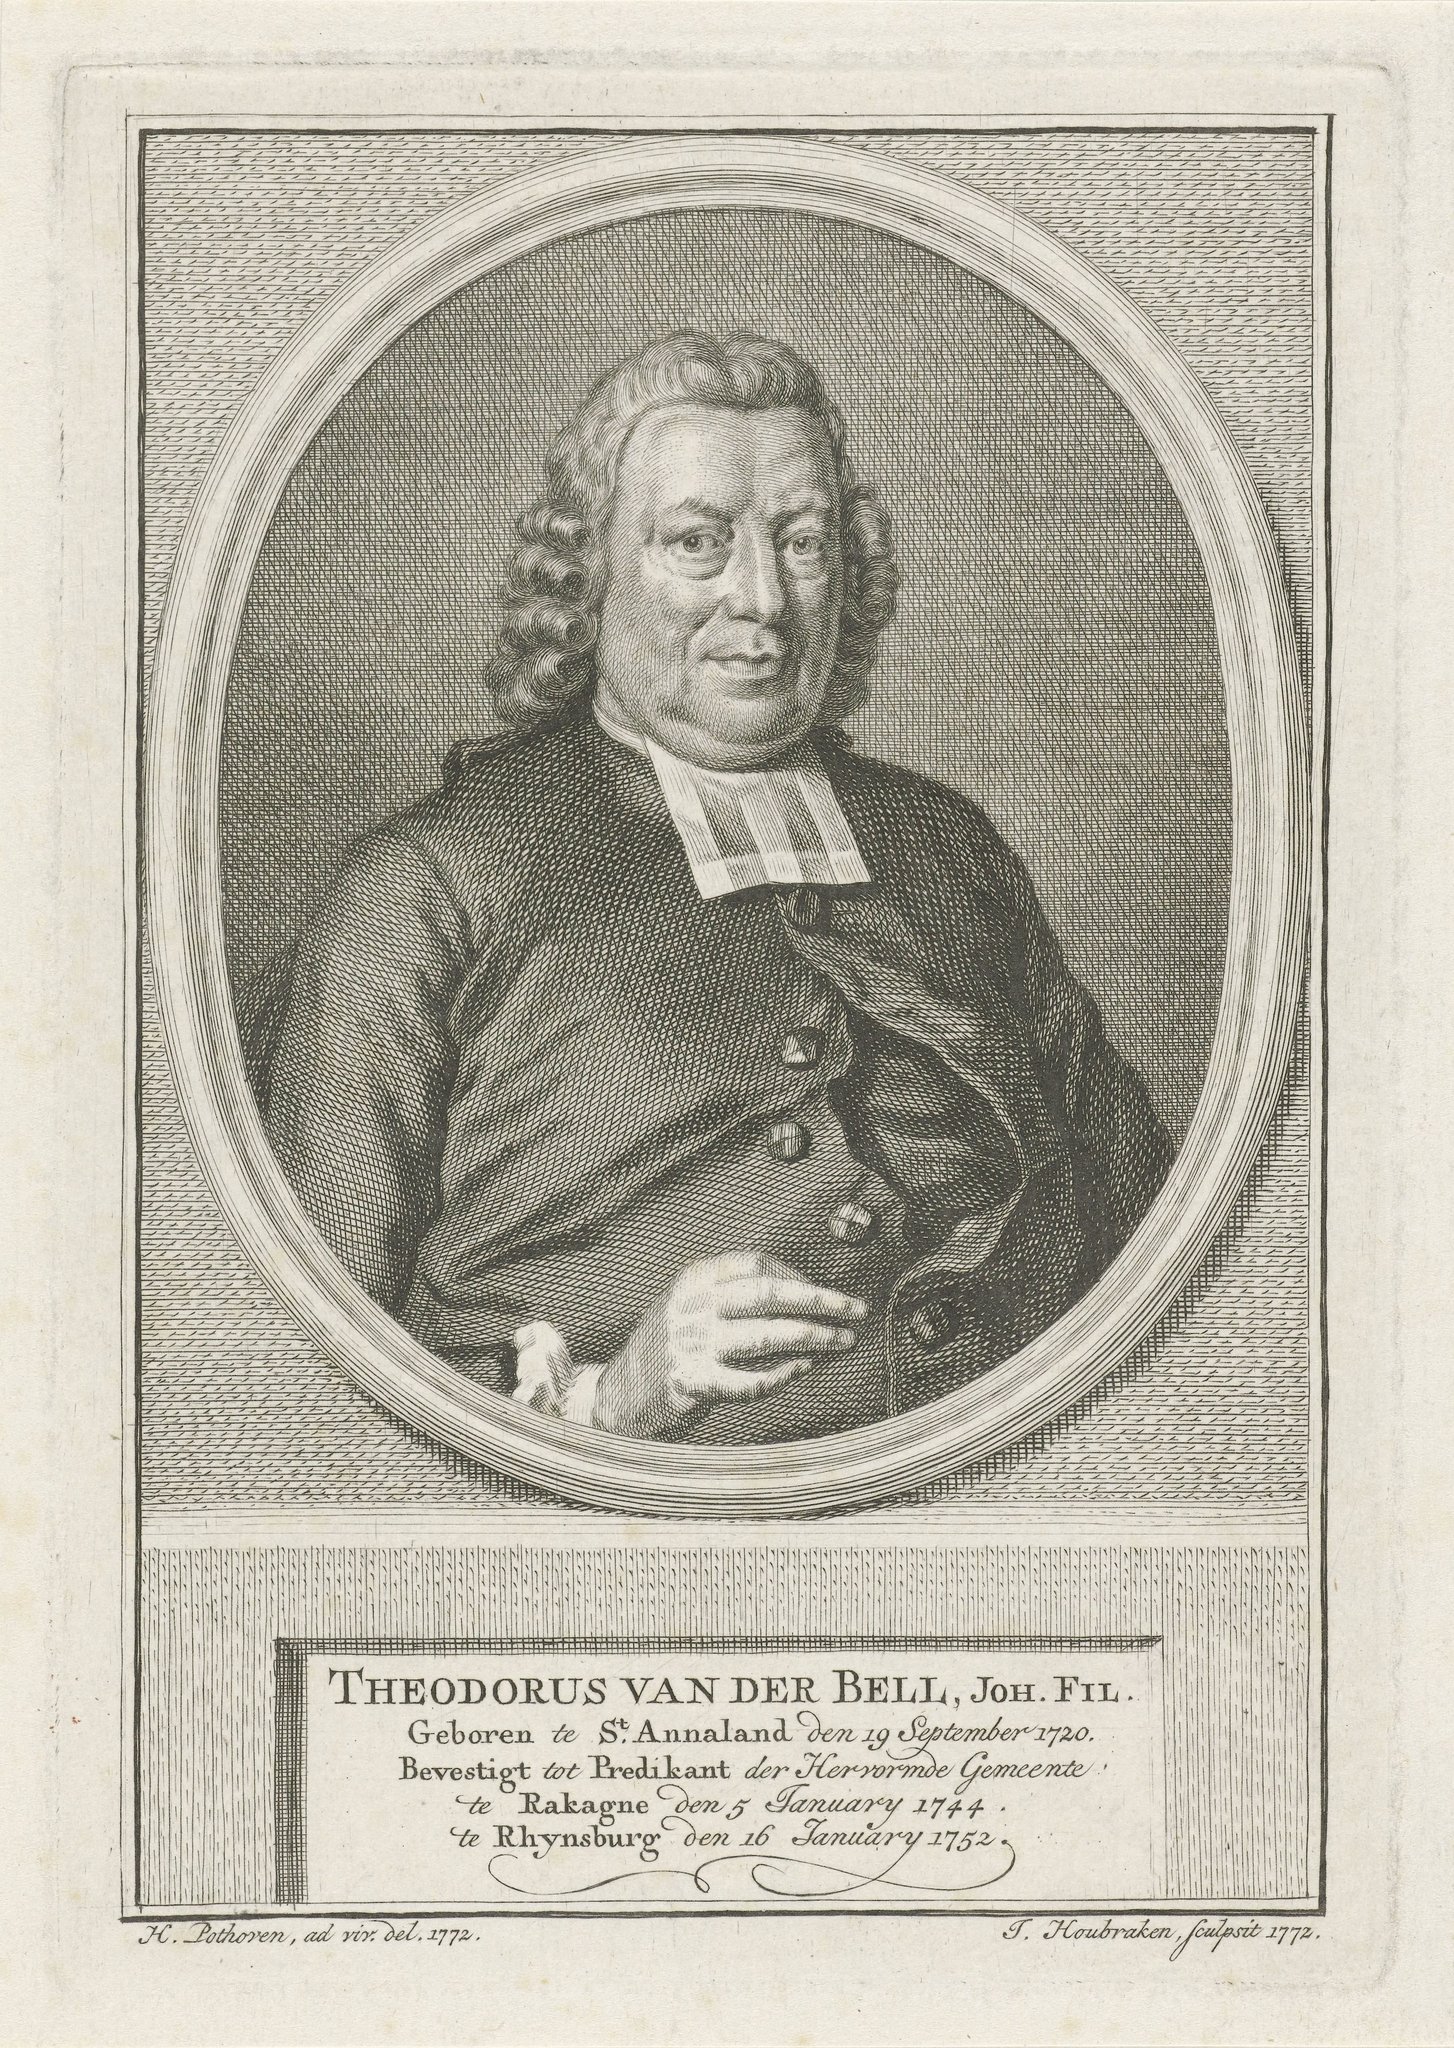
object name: print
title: Portret van Theodorus van der Bell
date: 1772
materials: paper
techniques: engraving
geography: amsterdam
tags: rijnsburg, predikant, theodorus van der bell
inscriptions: collector's mark: Lugt 240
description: Portret ten halven lijve van Theodorus van der Bell op 52-jarige leeftijd in een ovaal medaillon. Onder het portret zijn naam en gegevens.